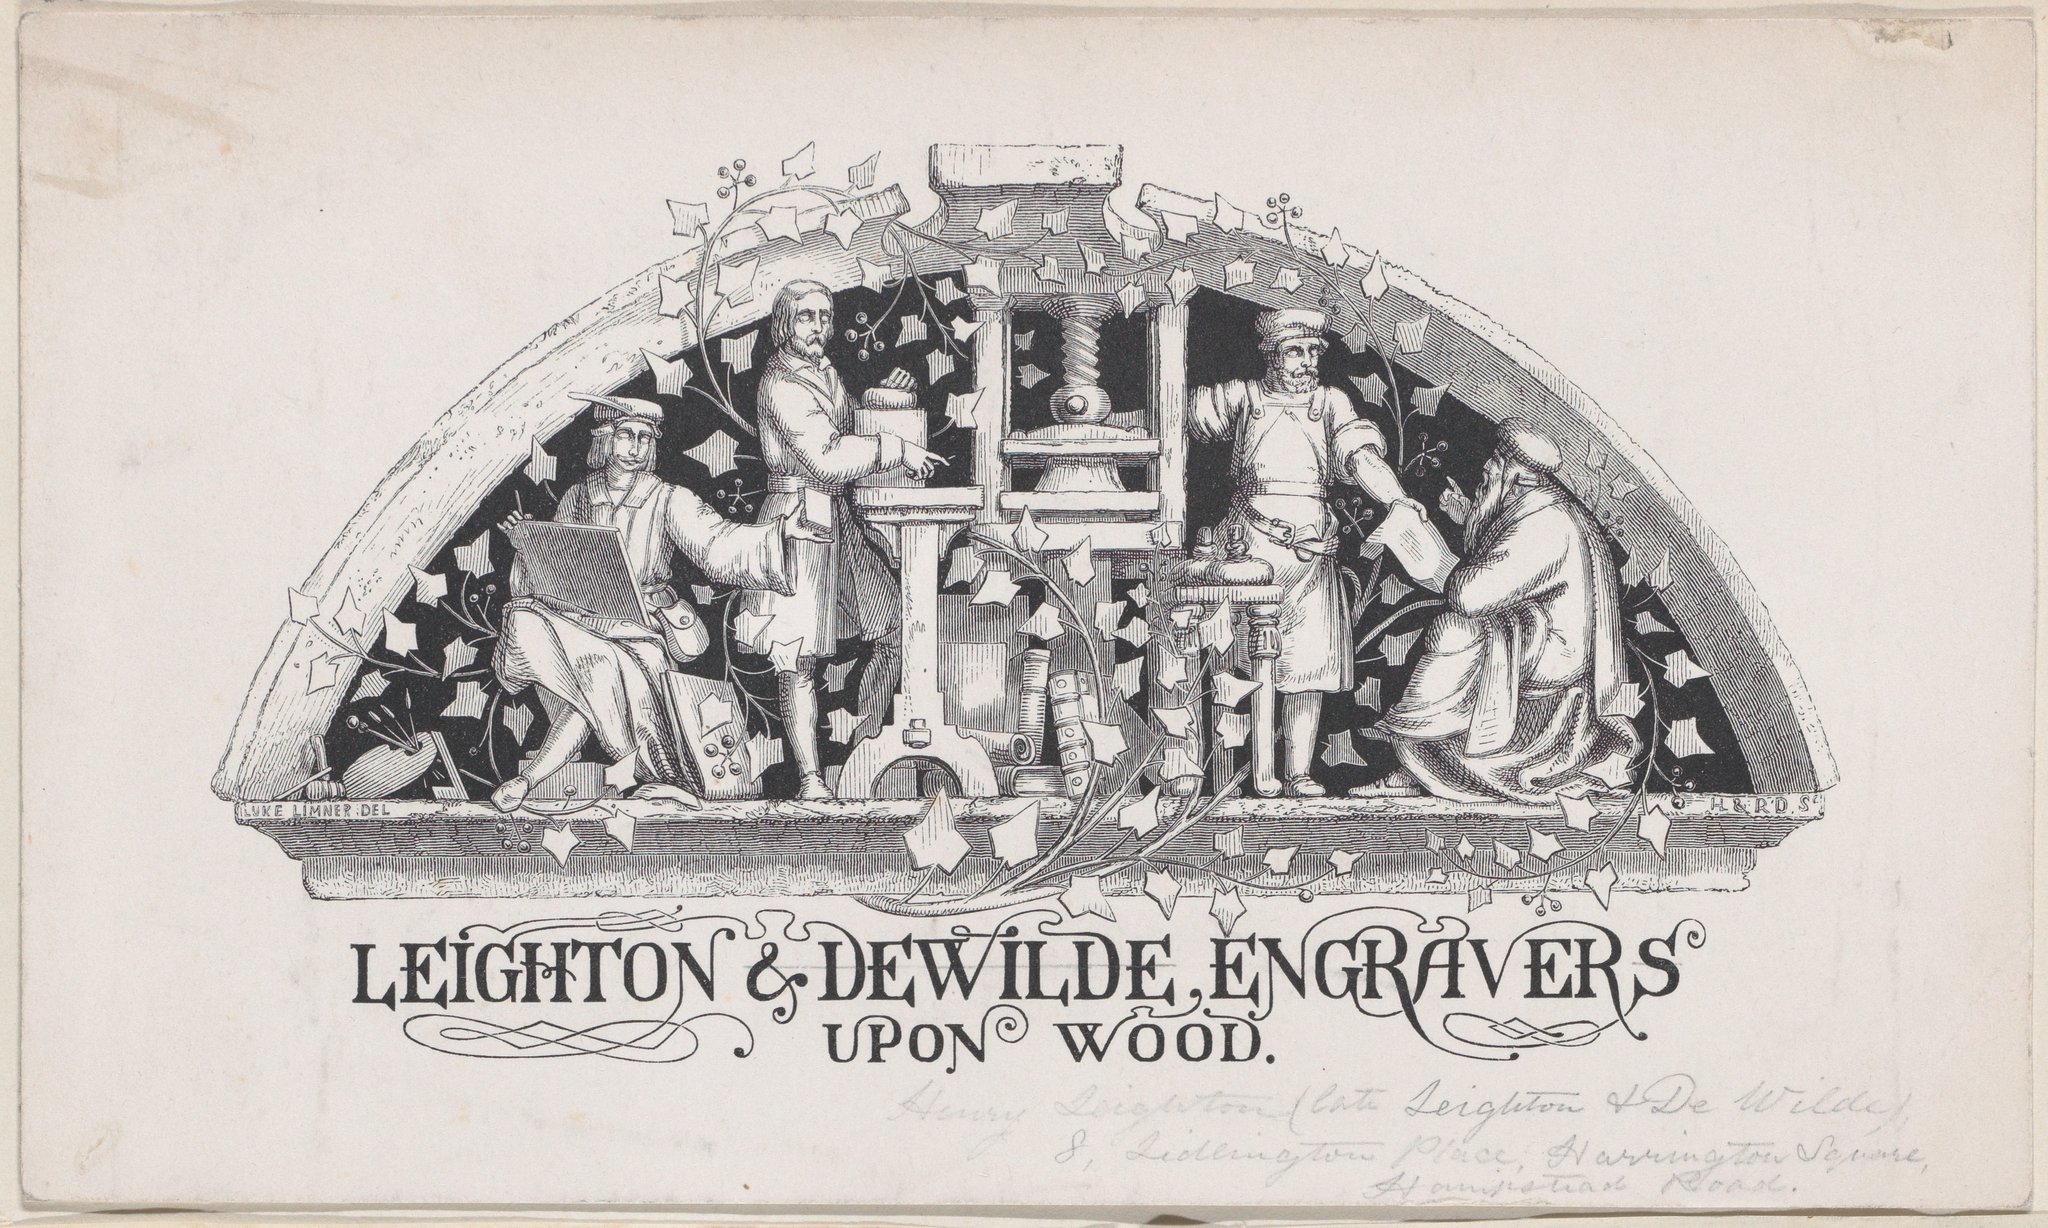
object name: print, trade card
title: Trade Card for Leighton & DeWilde, Wood Engravers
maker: anonymous, british, 19th century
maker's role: artist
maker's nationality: british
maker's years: 1800-1900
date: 1801-1900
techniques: engraving